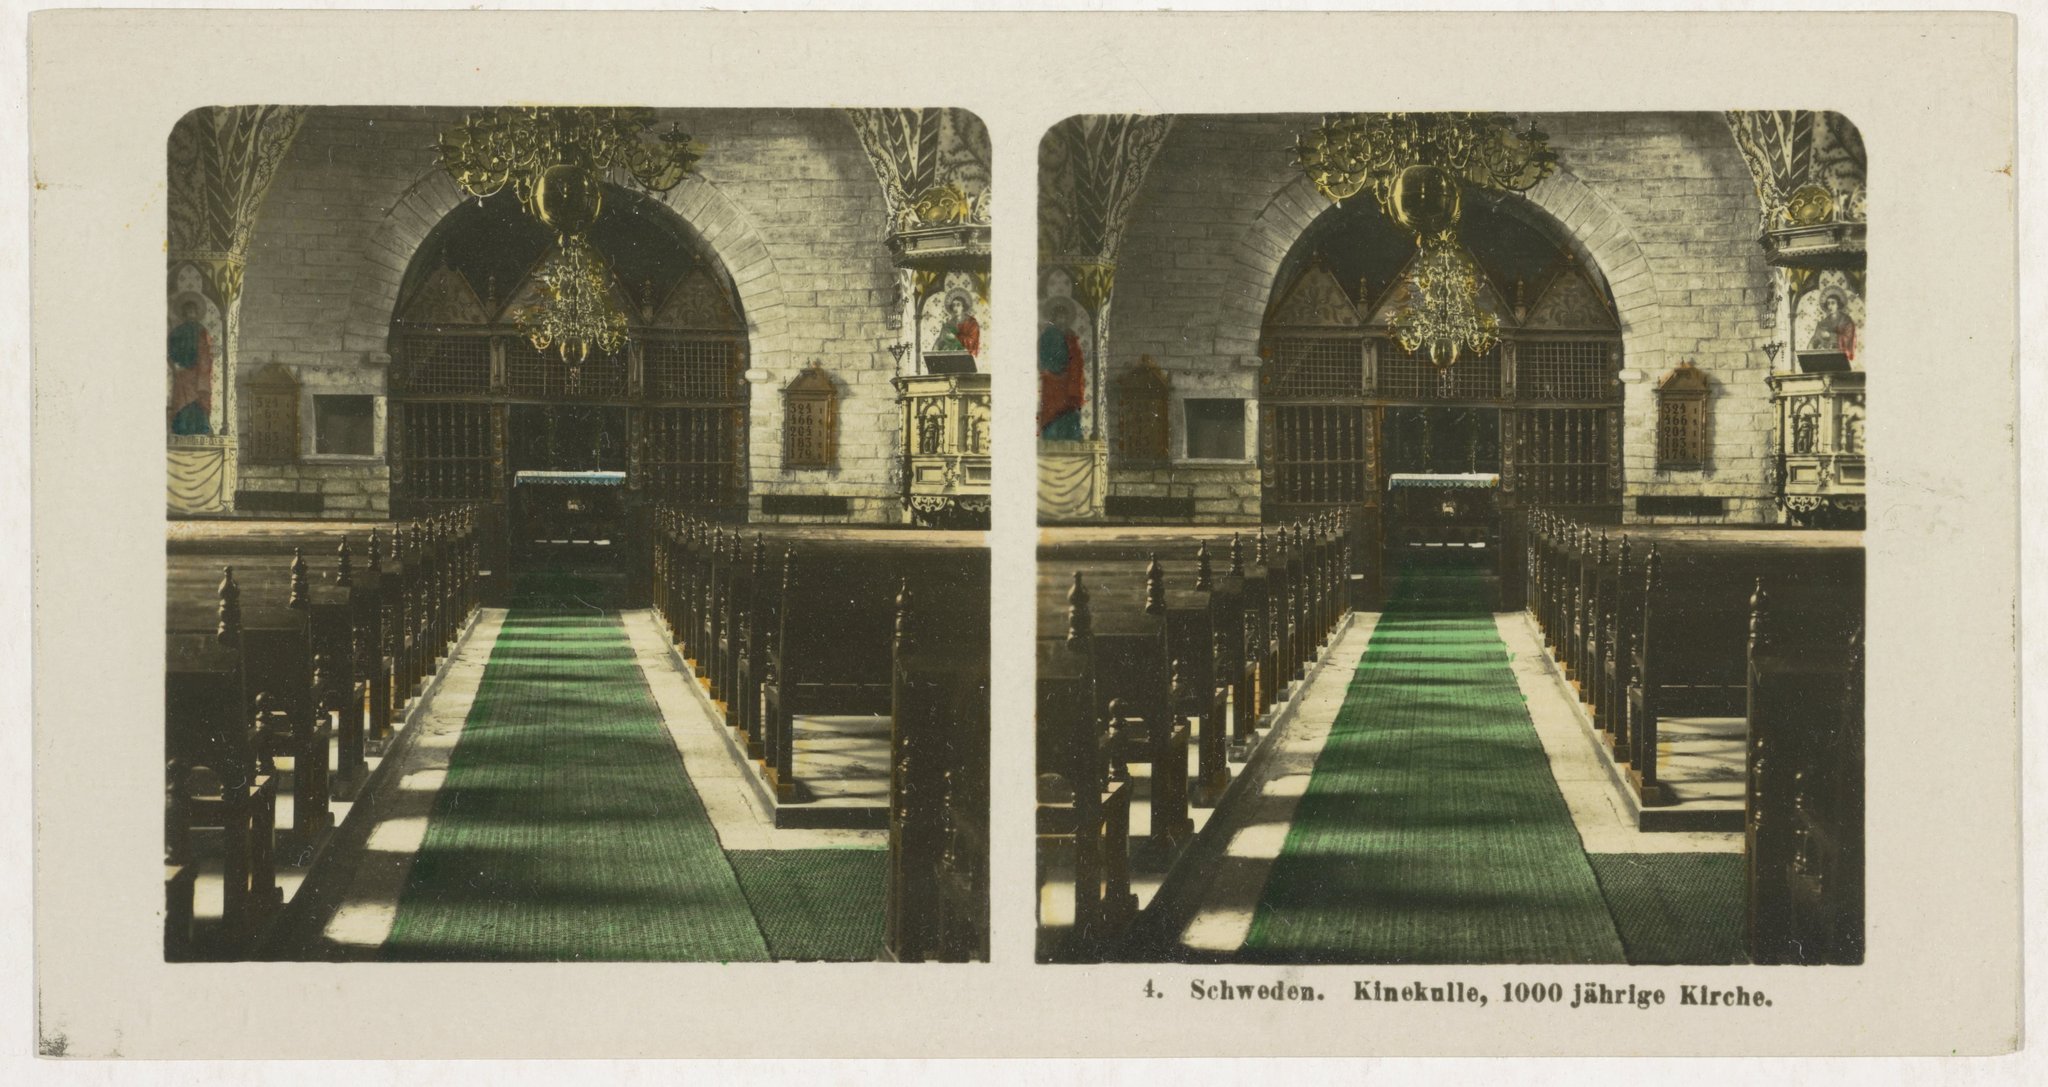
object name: stereograph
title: Schweden. Kinekulle, 1000 jährige Kirche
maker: bw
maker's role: fotograaf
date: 1898-1935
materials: paper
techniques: gelatin silver print, hand coloring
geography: husaby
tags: interior of church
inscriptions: inscription: ‘Schweden. Kinekulle. 1000jährige Kirche./ Sweden. Kinekulle. Church 1000 years old./ Suède. Kinekulle. Eglise de 1000 ans./ Suecia. Kinekulle. Iglesia de 1000 años.’, number: ‘4’, monogram: ‘BW’